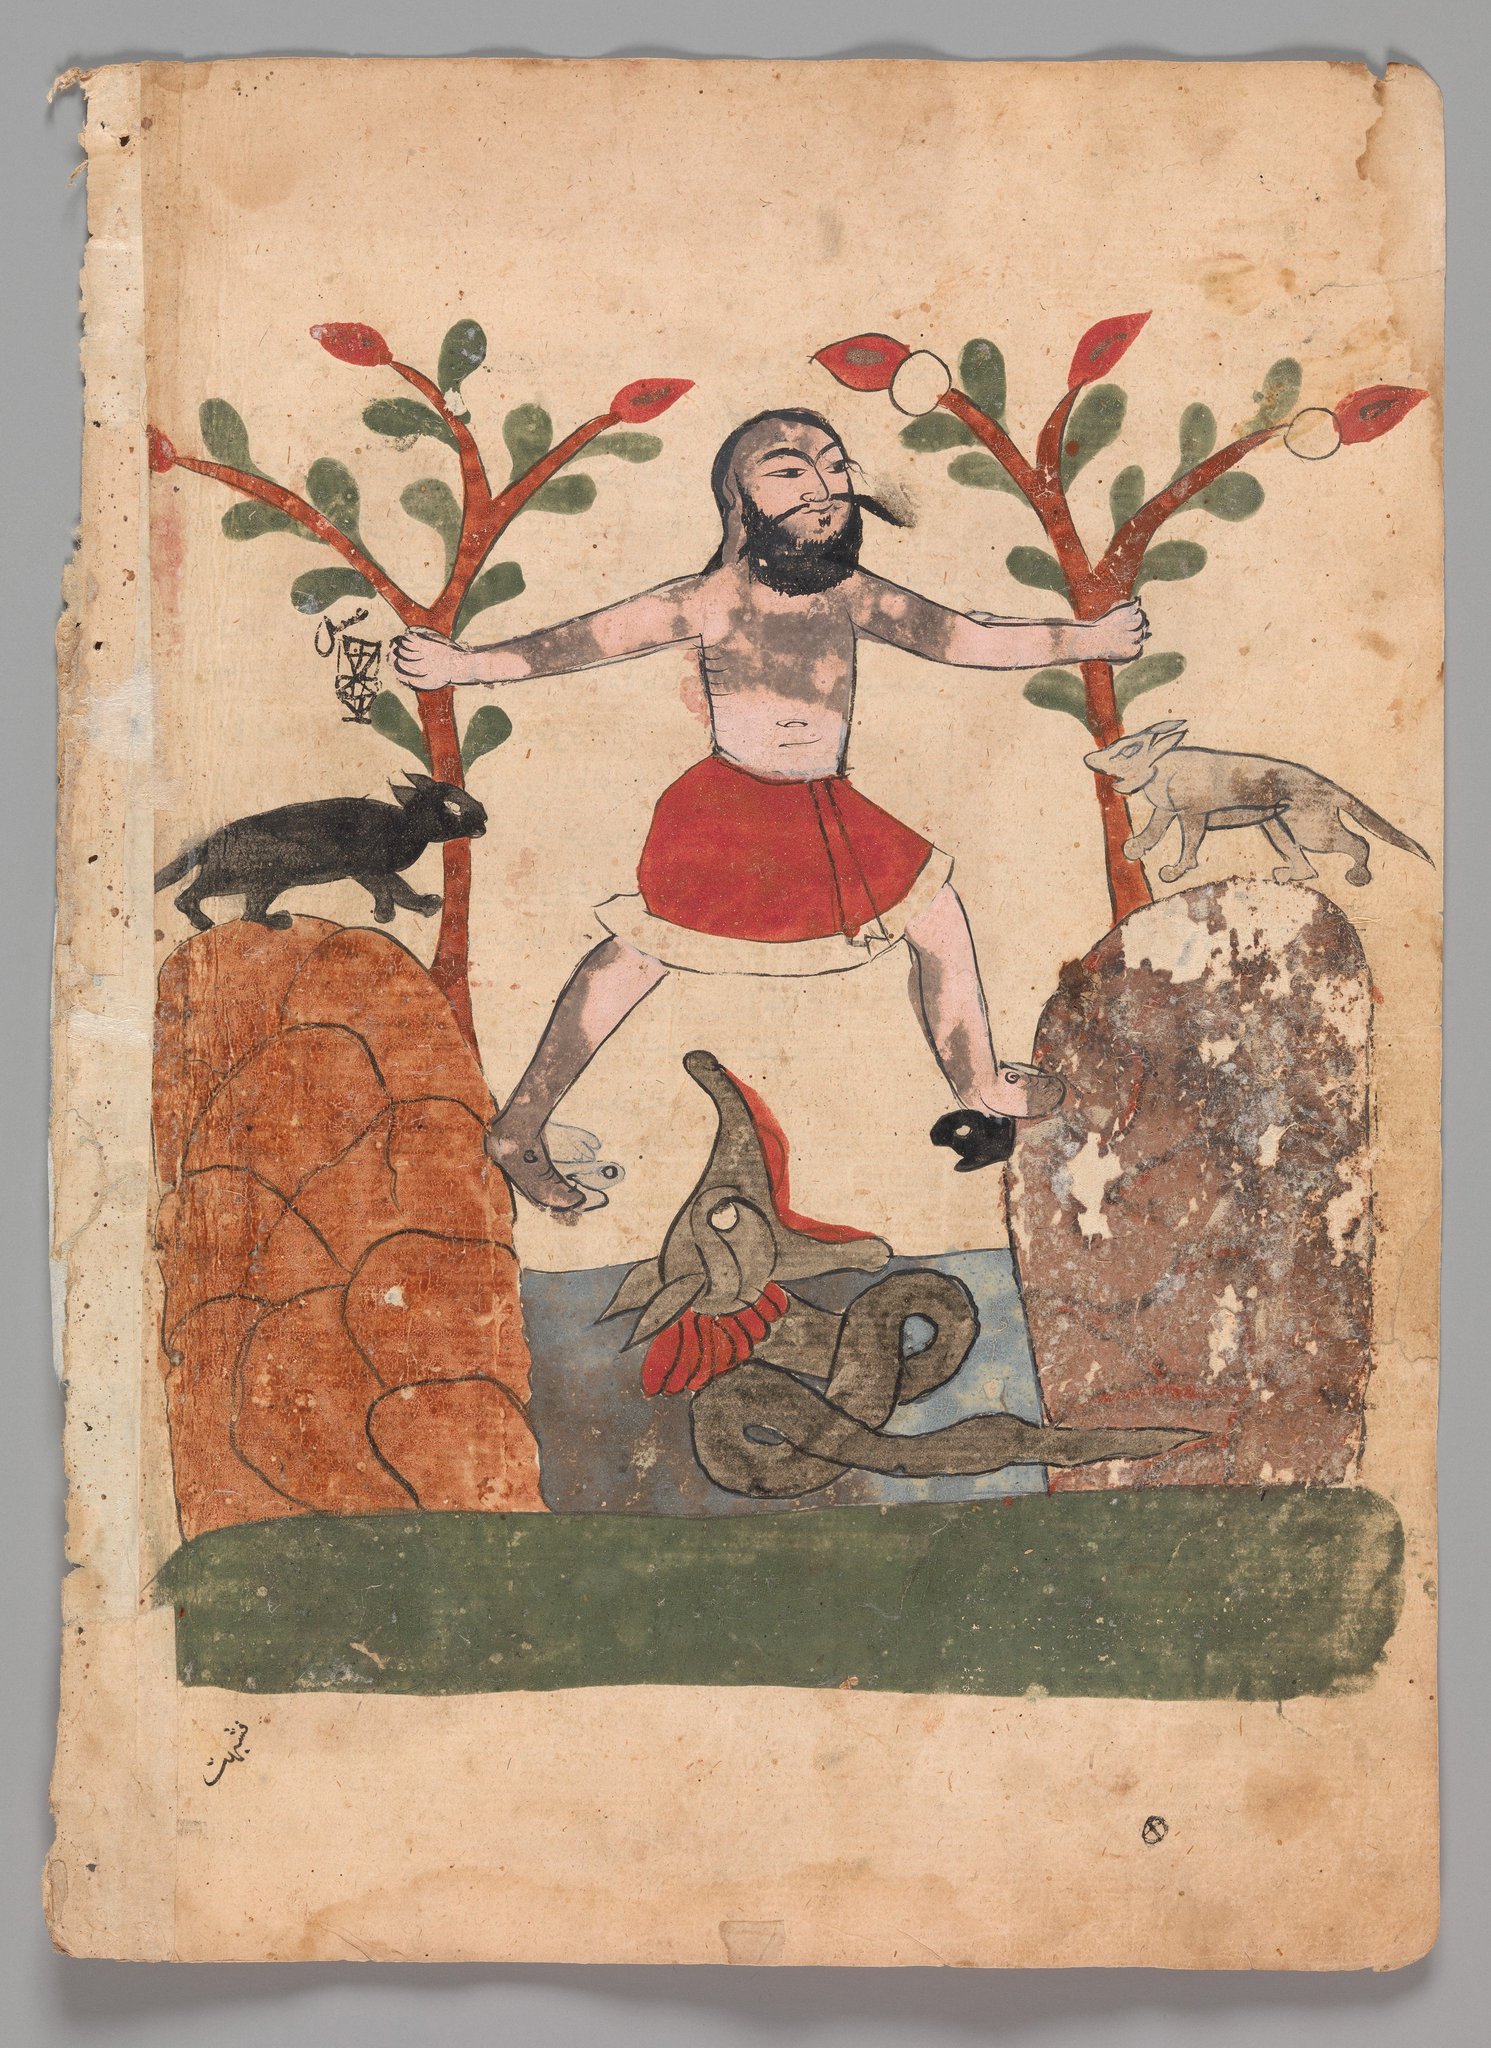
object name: folio from an illustrated manuscript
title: "Man's Fate or the Man Taking Refuge in a Well Inhabited by a Dragon", Folio from a Kalila wa Dimna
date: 1526-1550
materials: ink, paper, watercolor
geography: india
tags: animals,men,dragons,trees